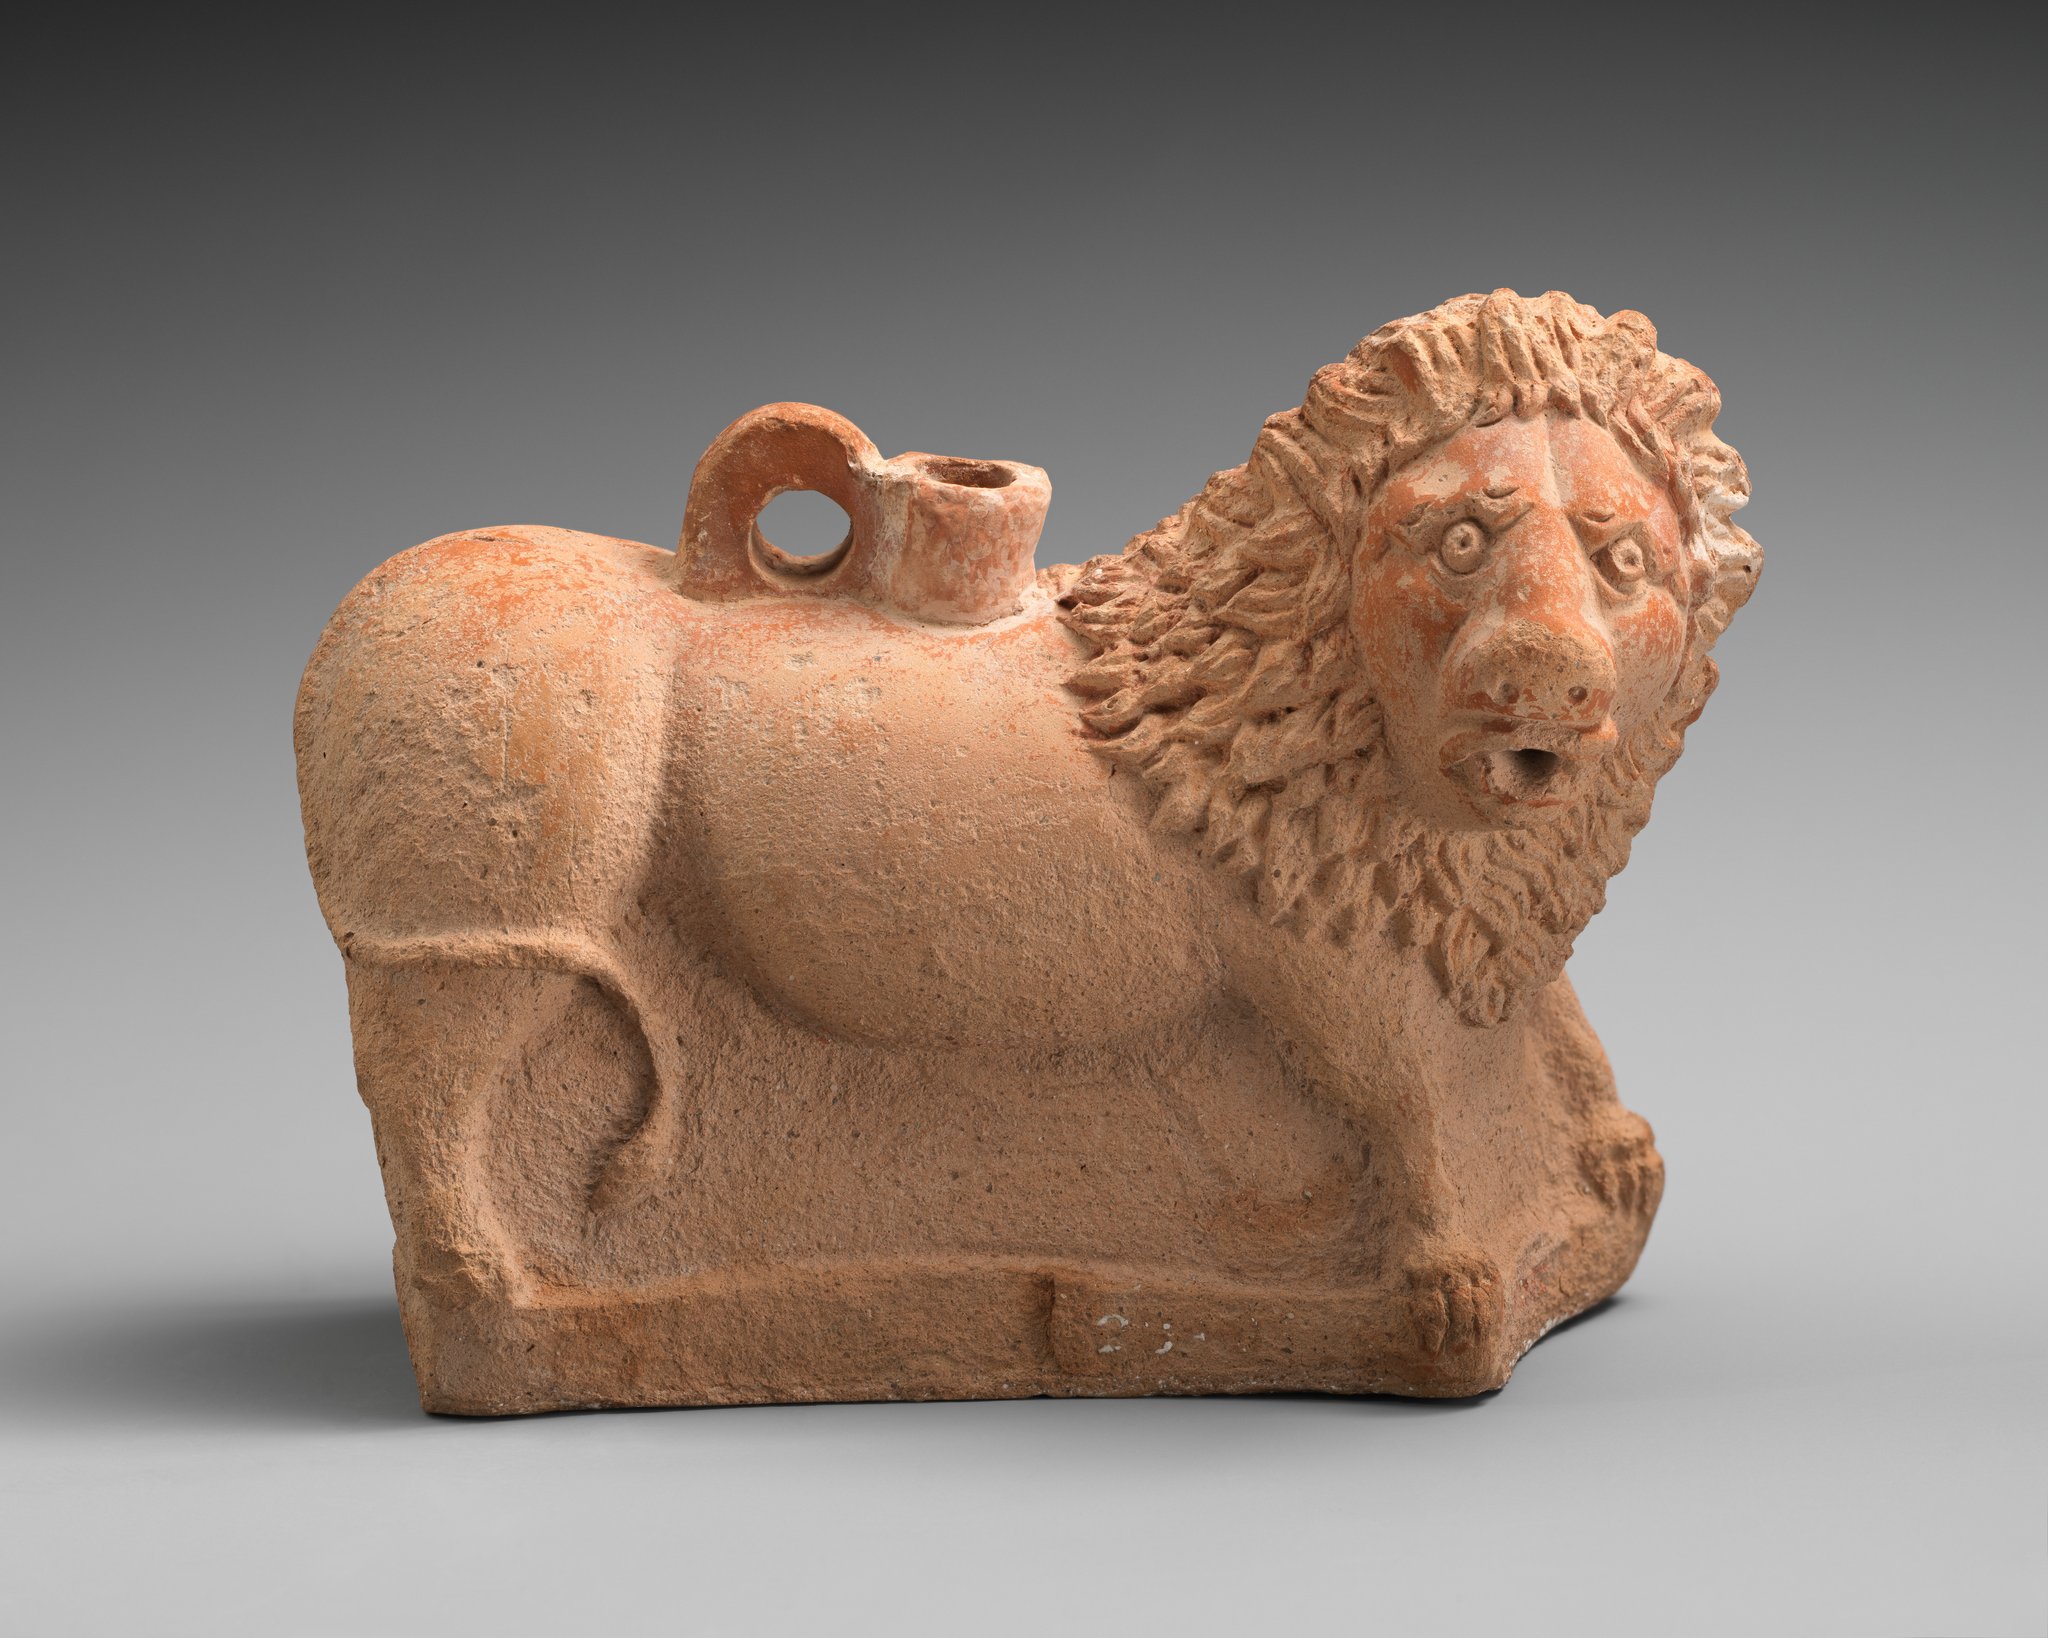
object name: vase in the form of a lion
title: Terracotta vase in the form of a lion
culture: roman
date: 101-200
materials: terracotta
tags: lions